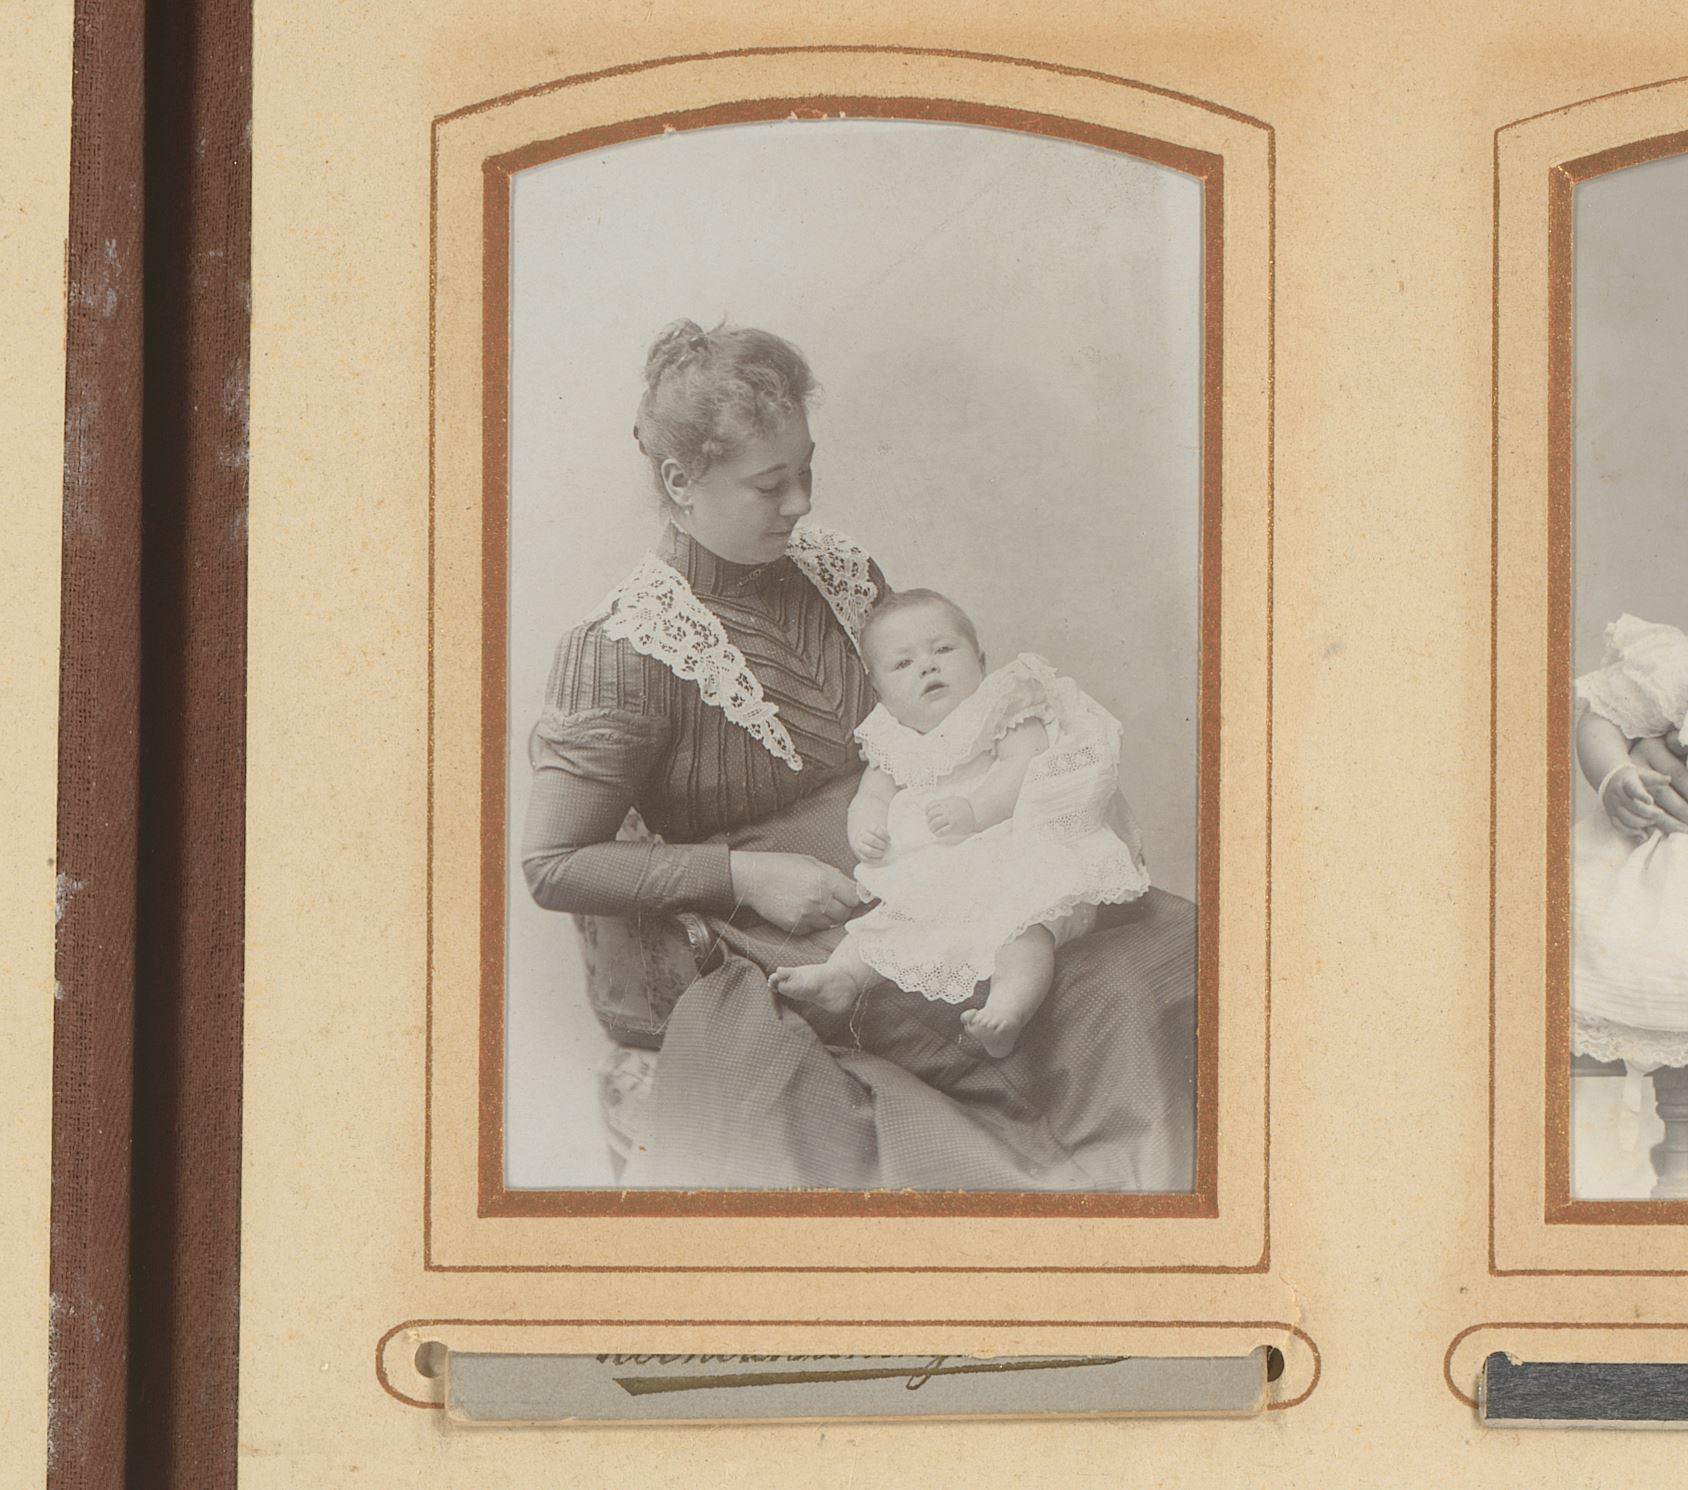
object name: photograph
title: Portret van een moeder met kind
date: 1887-1920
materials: cardboard, photographic support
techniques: collodion silver print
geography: amsterdam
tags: mother and baby or young child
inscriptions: inscription: ‘Koene & Büttinghausen’